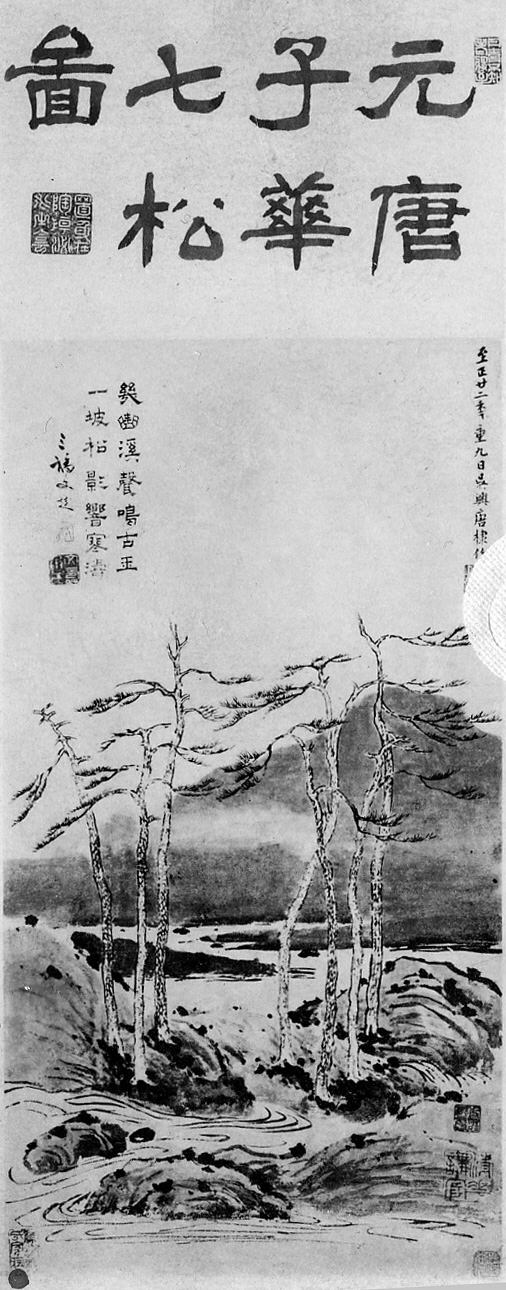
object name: hanging scroll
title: The Seven Pines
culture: chinese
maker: unidentified artist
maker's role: artist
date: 1368-1911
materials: paper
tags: landscapes,trees